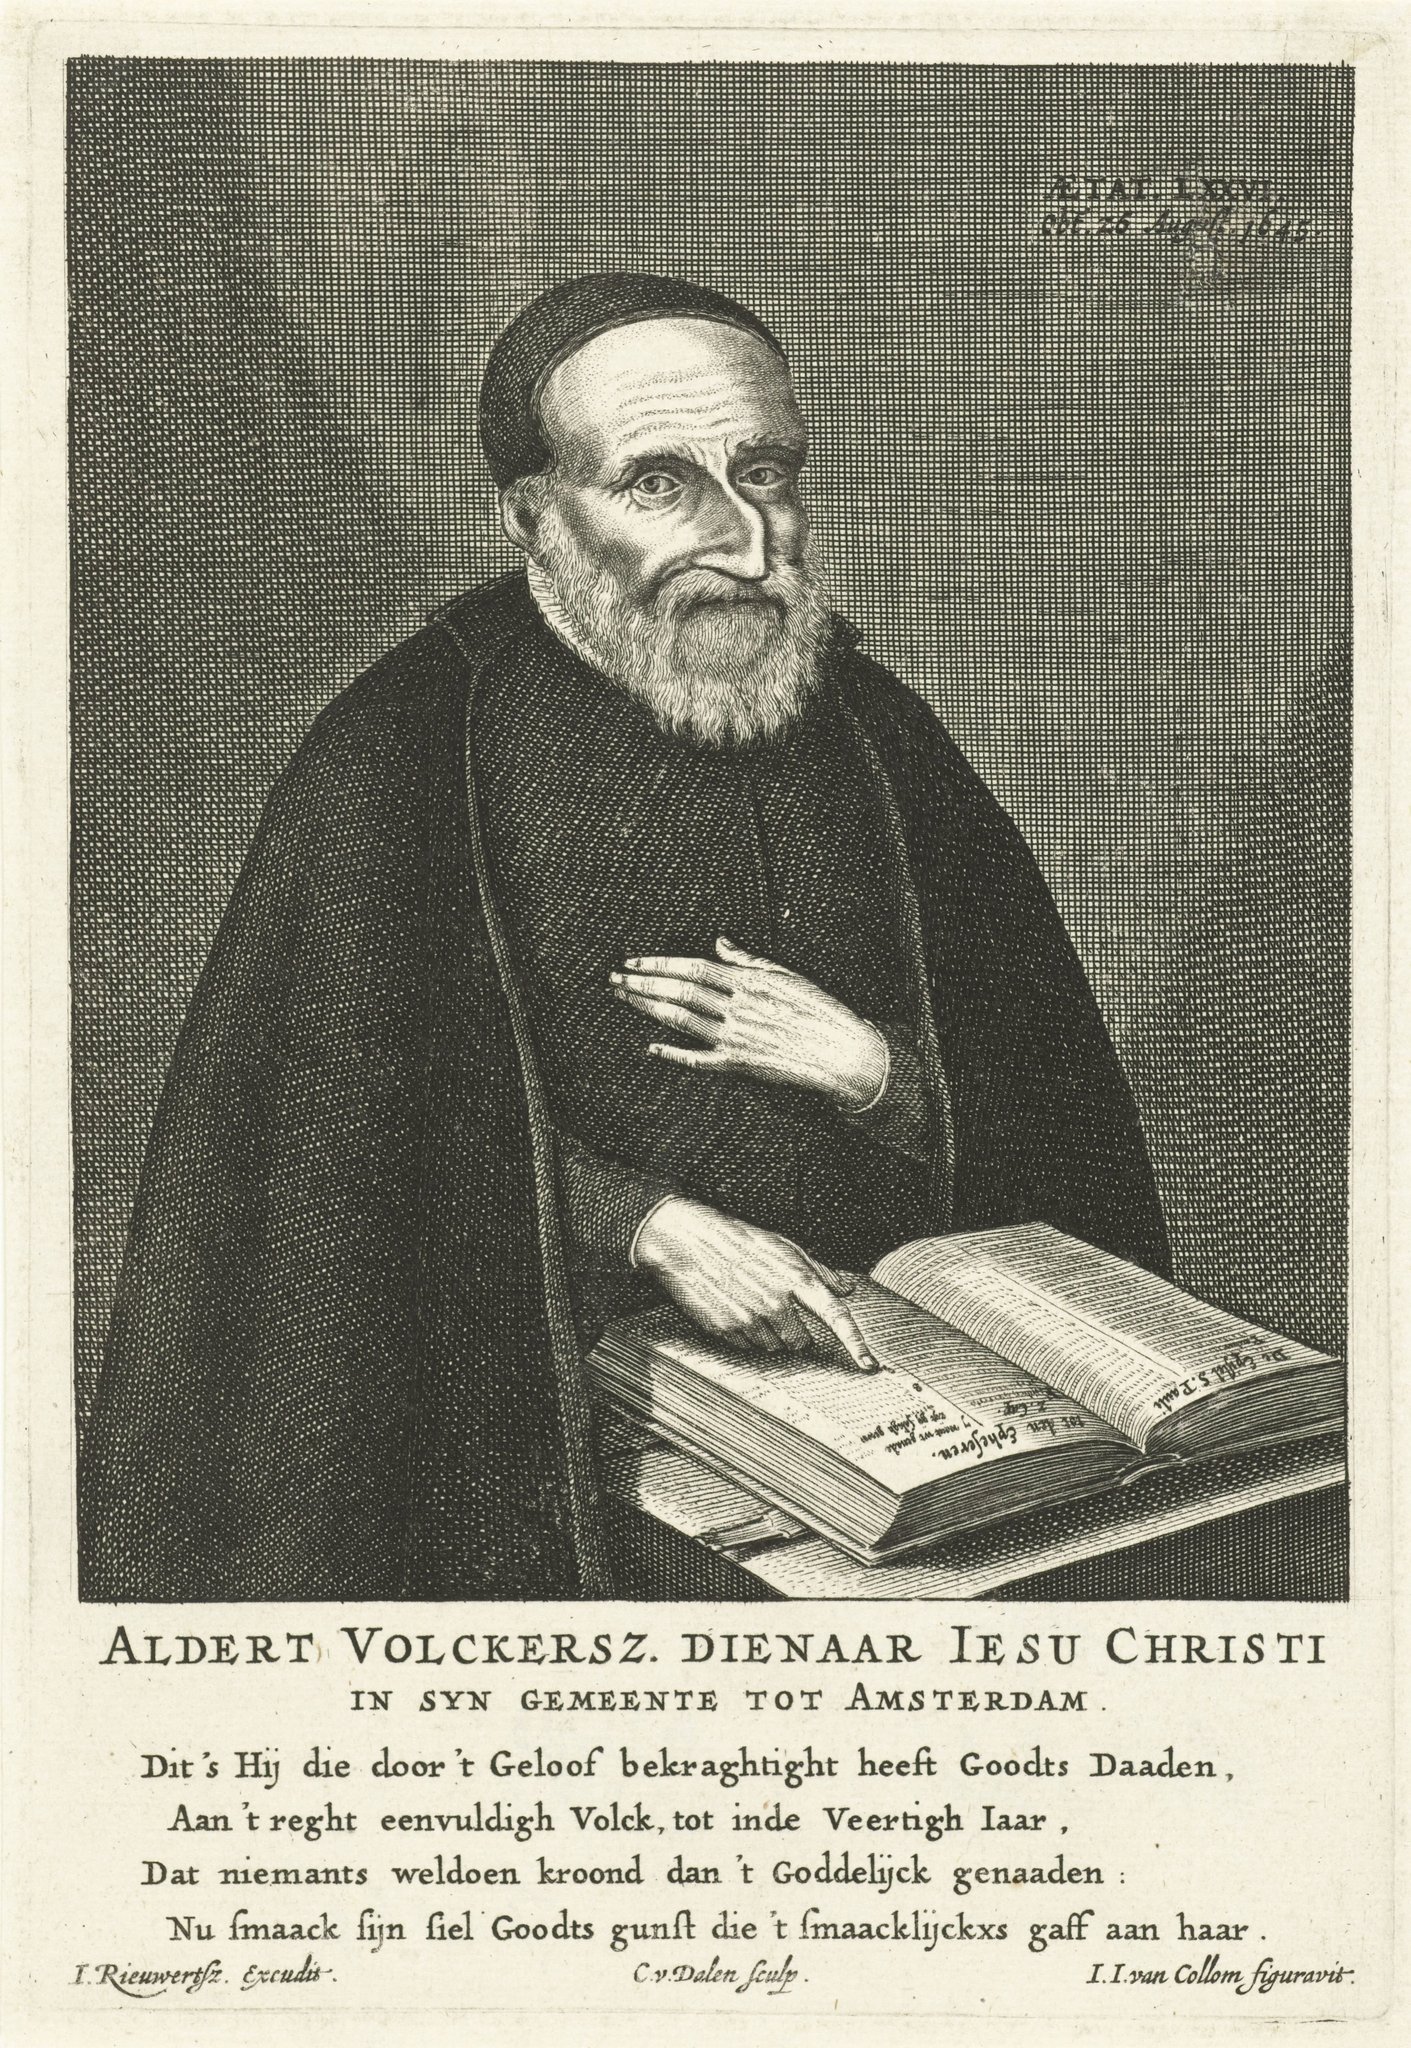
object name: print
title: Portret van Aldert Volckersz. op 76-jarige leeftijd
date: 1645-1665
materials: paper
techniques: engraving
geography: amsterdam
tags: aldert volkerts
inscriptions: collector's mark: Lugt 2228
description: Portret van doopsgezind predikant Aldert Volckersz., ten halven lijve zittend met bijbel. In de marge onder een Nederlands vers.